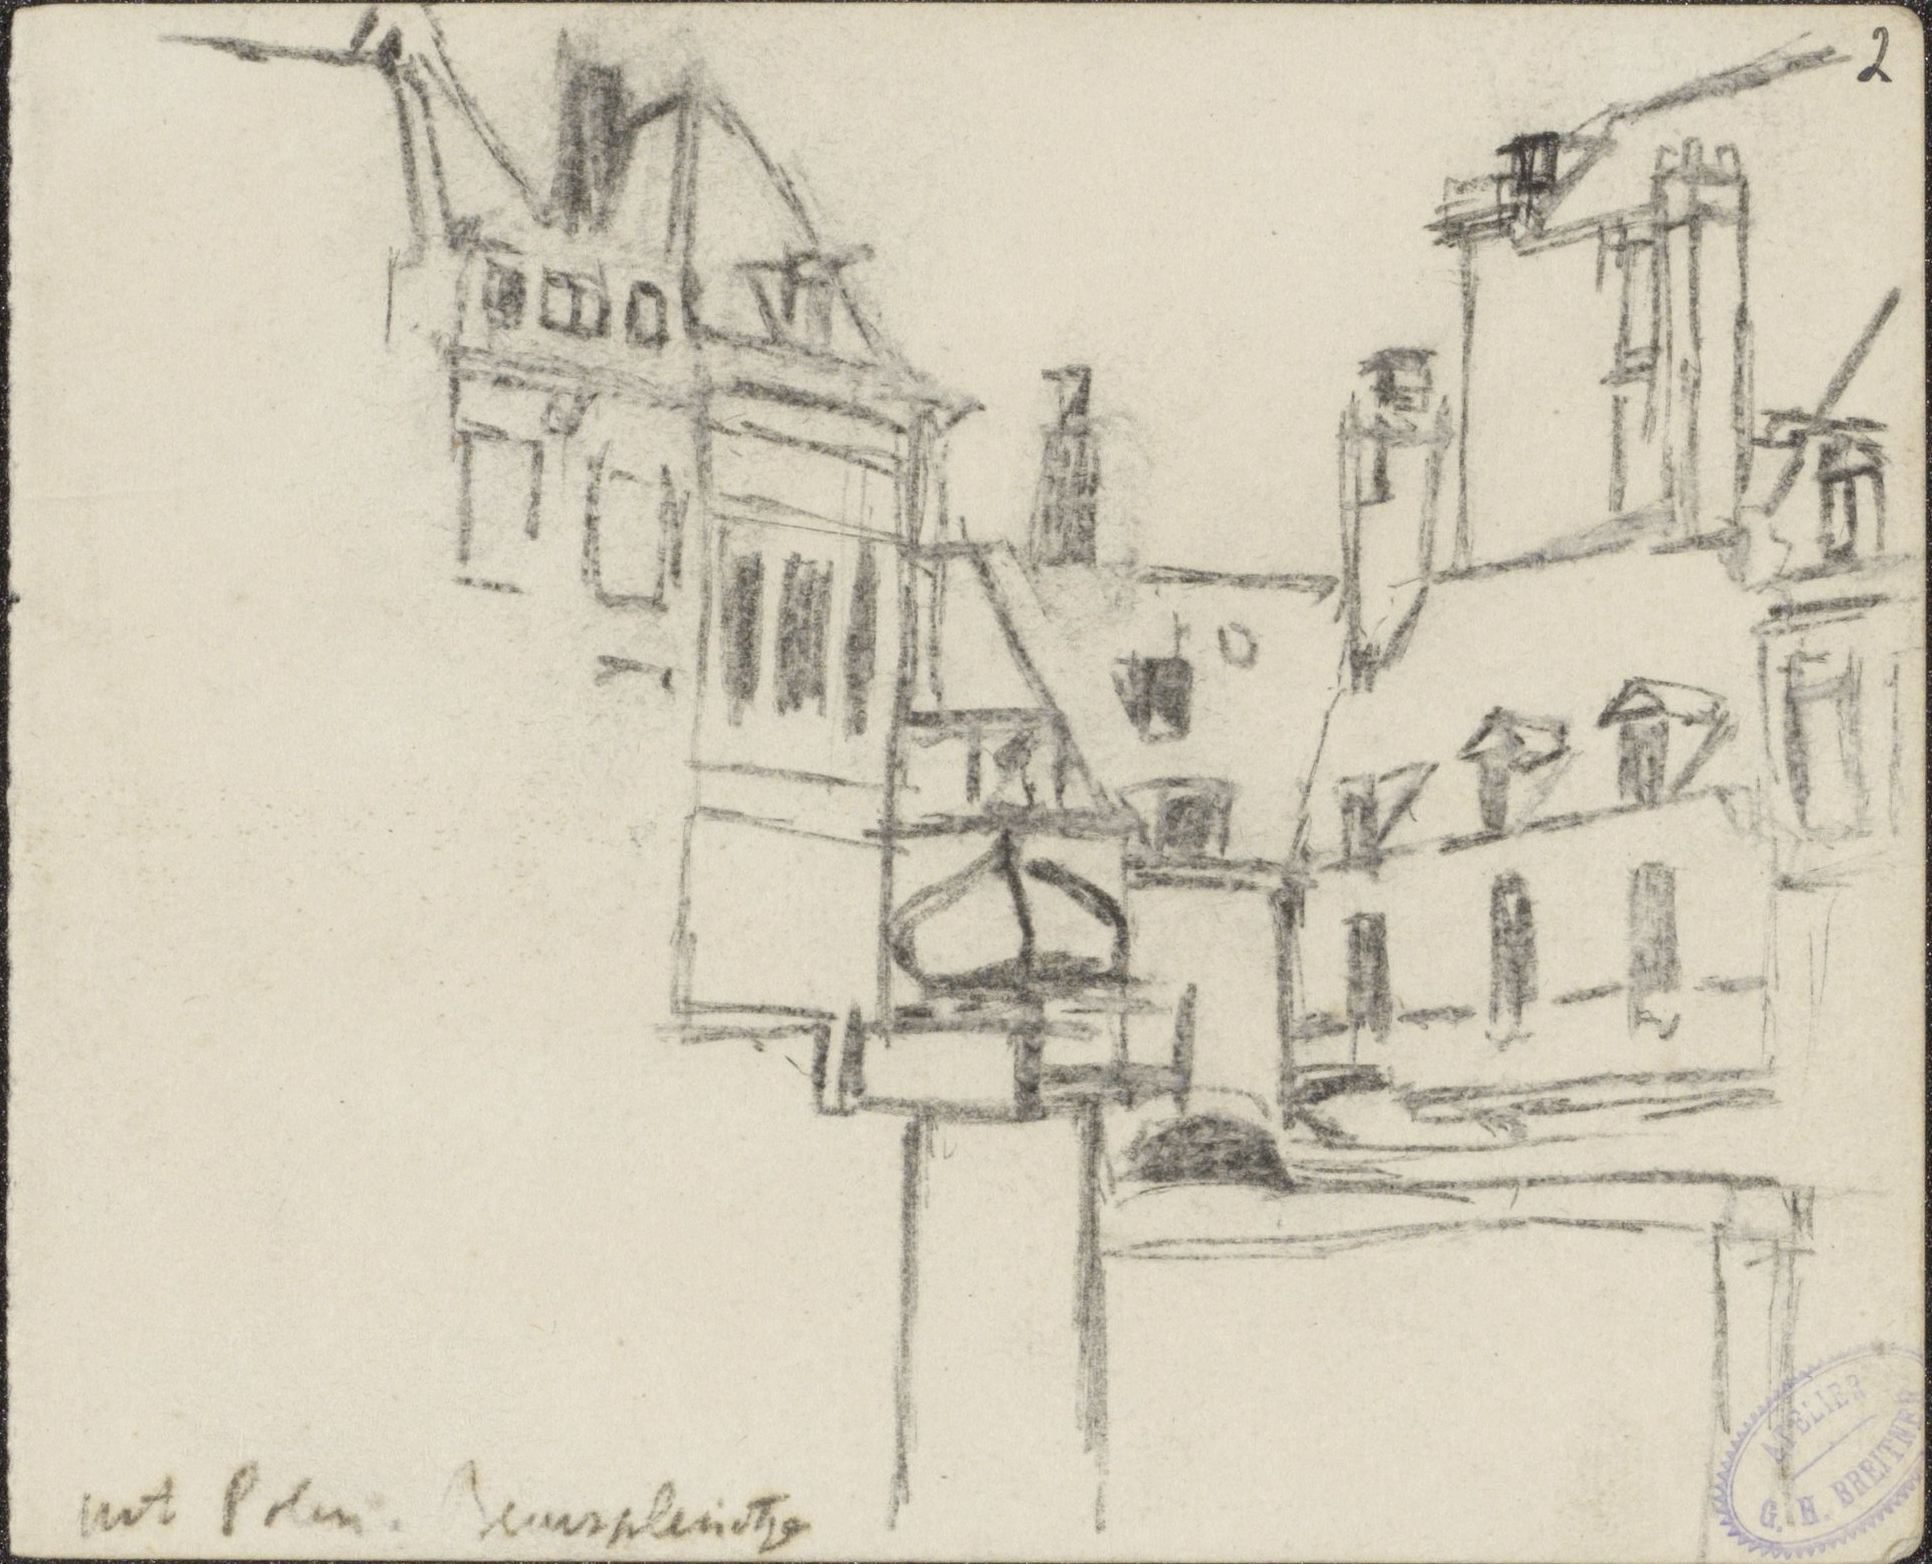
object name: drawing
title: Gezicht op het Beurspleintje te Amsterdam, gezien vanuit Hotel Polen (Rokin 14)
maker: george hendrik breitner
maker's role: draughtsman, painter, print maker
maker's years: 1857-1923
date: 1908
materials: chalk, paper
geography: amsterdam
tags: square, place, circus, etc., urban housing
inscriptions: collector's mark: Lugt 2228, workshop stamp: Lugt 291d, annotation: ‘uit Polen, Beurspleintje’